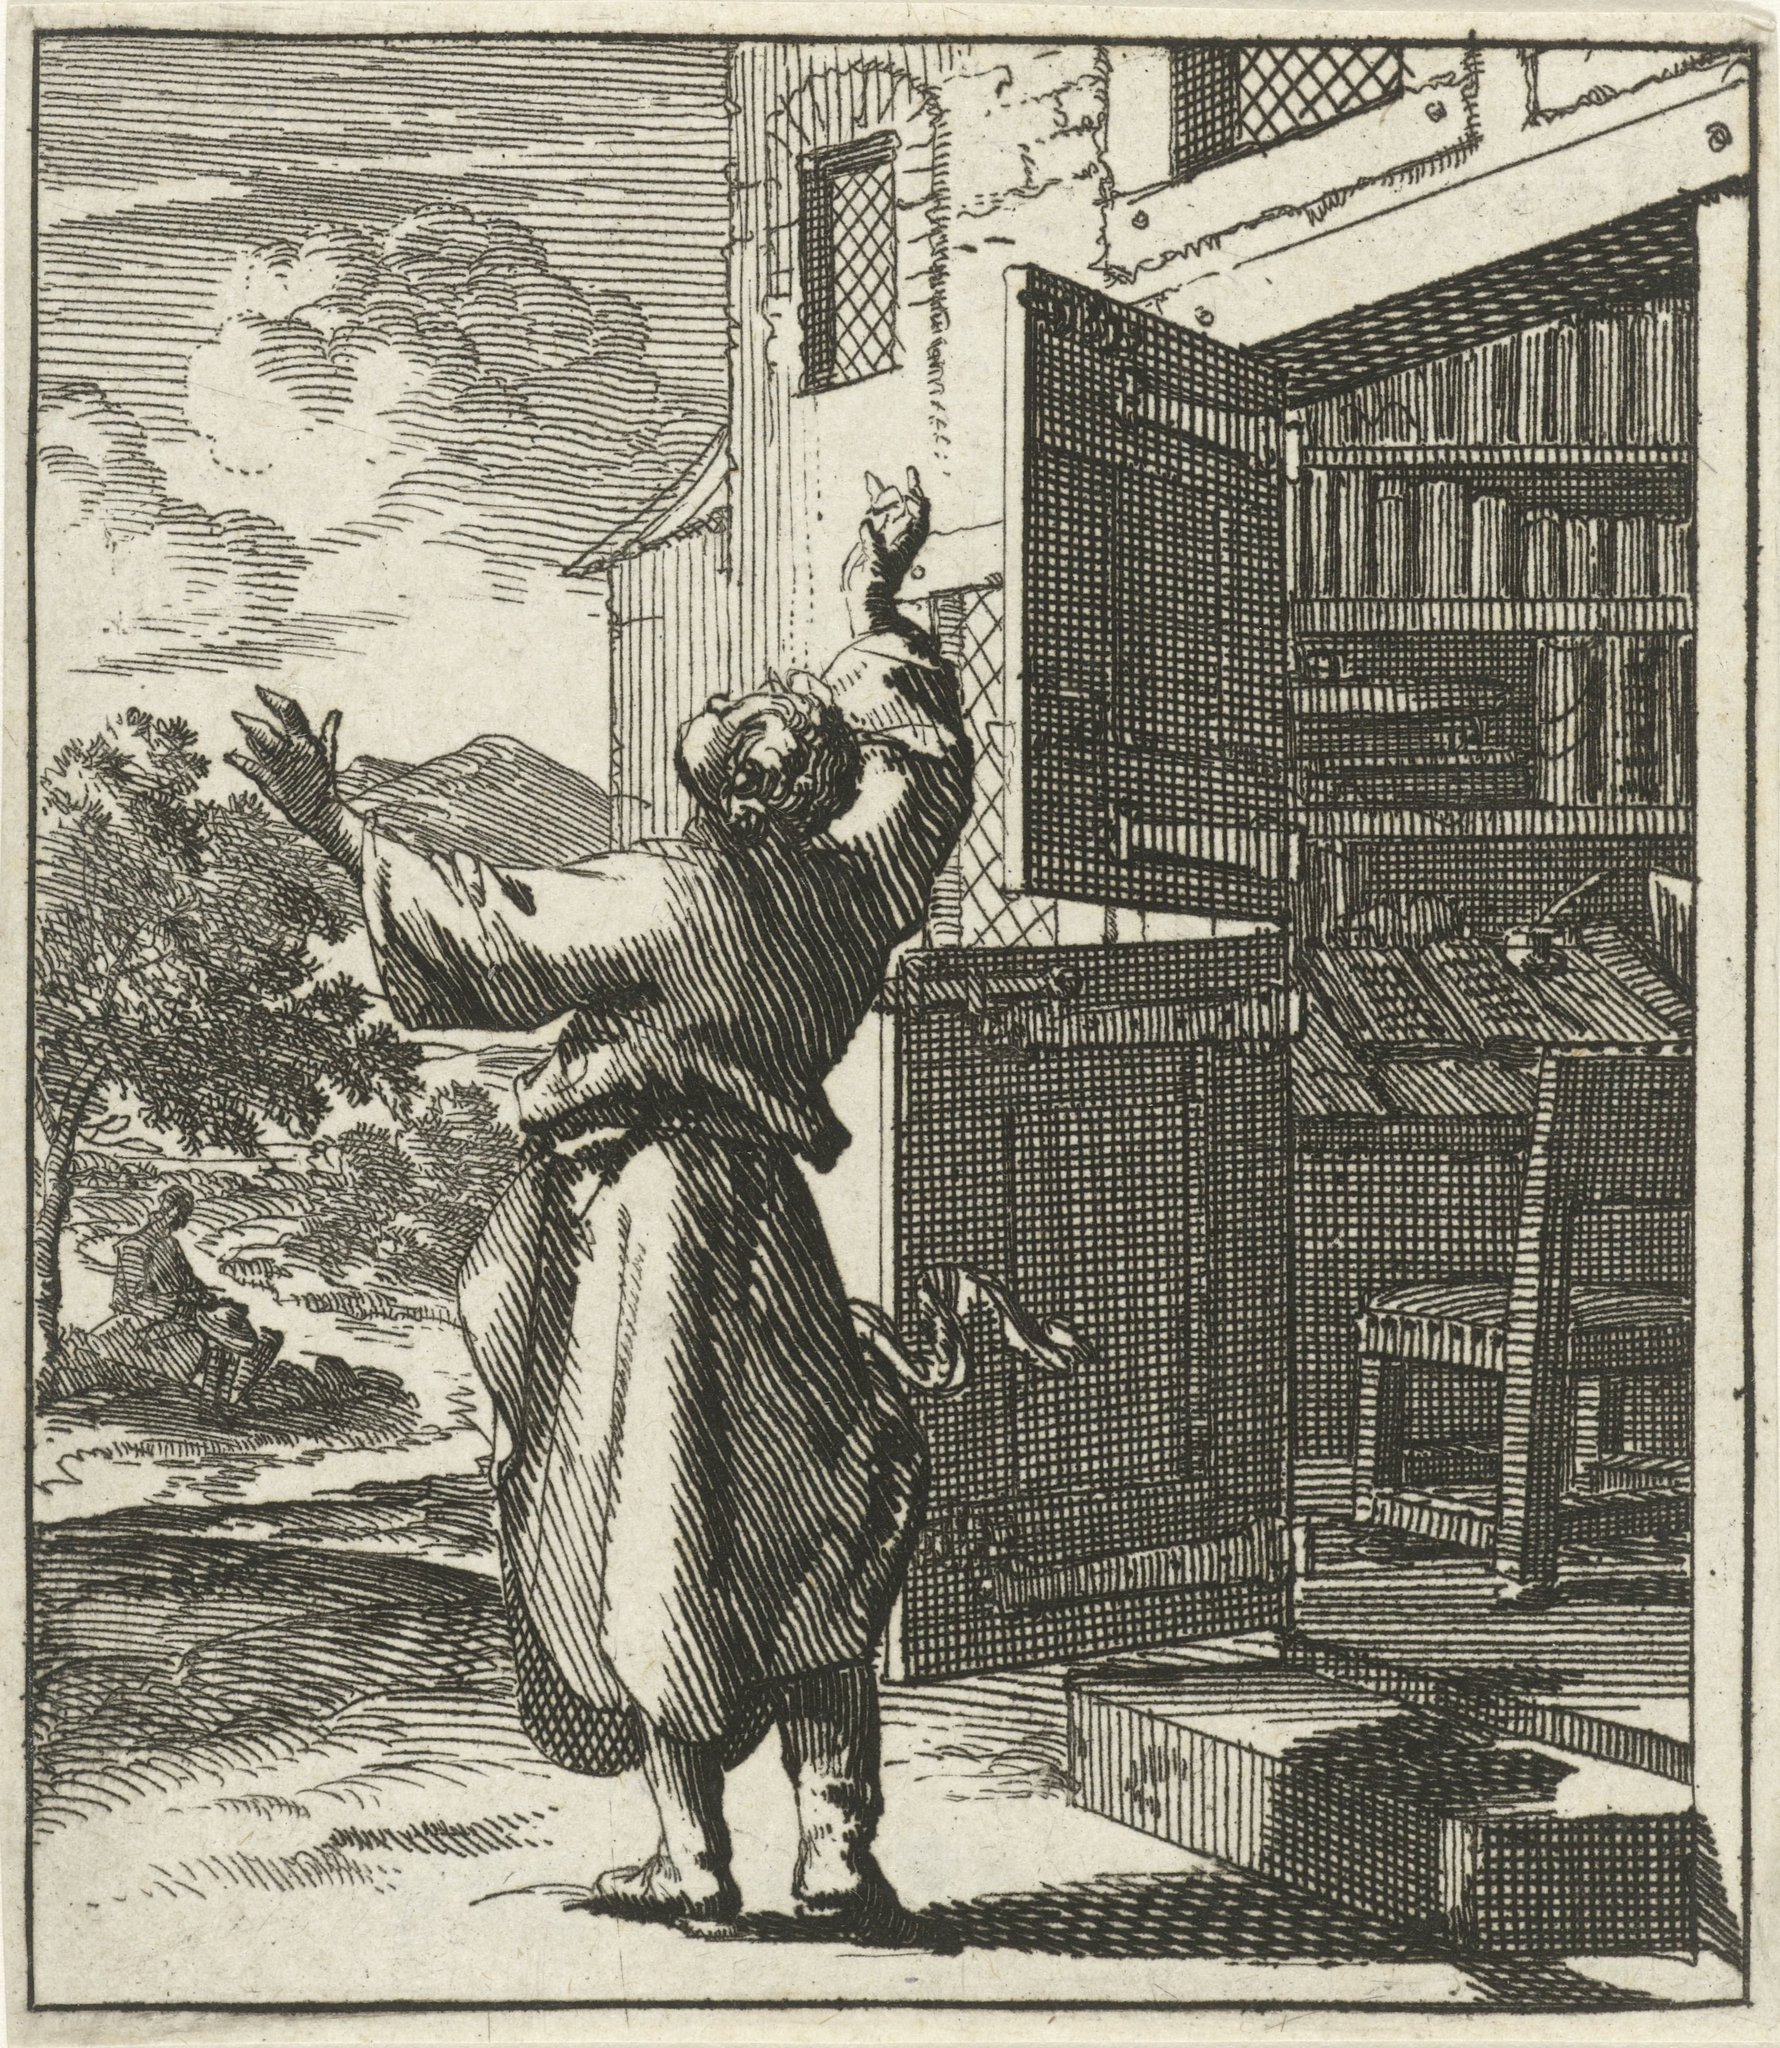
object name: book illustration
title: Leert 't onderzoek ons iet: Veel klaarder 't zelf-geniet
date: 1689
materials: paper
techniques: etching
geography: amsterdam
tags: contemplating the firmament, study; 'studiolo'; library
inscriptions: collector's mark: Lugt 2228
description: Illustratie uit: Huygen, Pieter. De beginselen van Gods koninkryk in den mensch uitgedrukt in zinnebeelden. Amsterdam: wed. Arentsz. Pieter (II), 1689, p. 116.